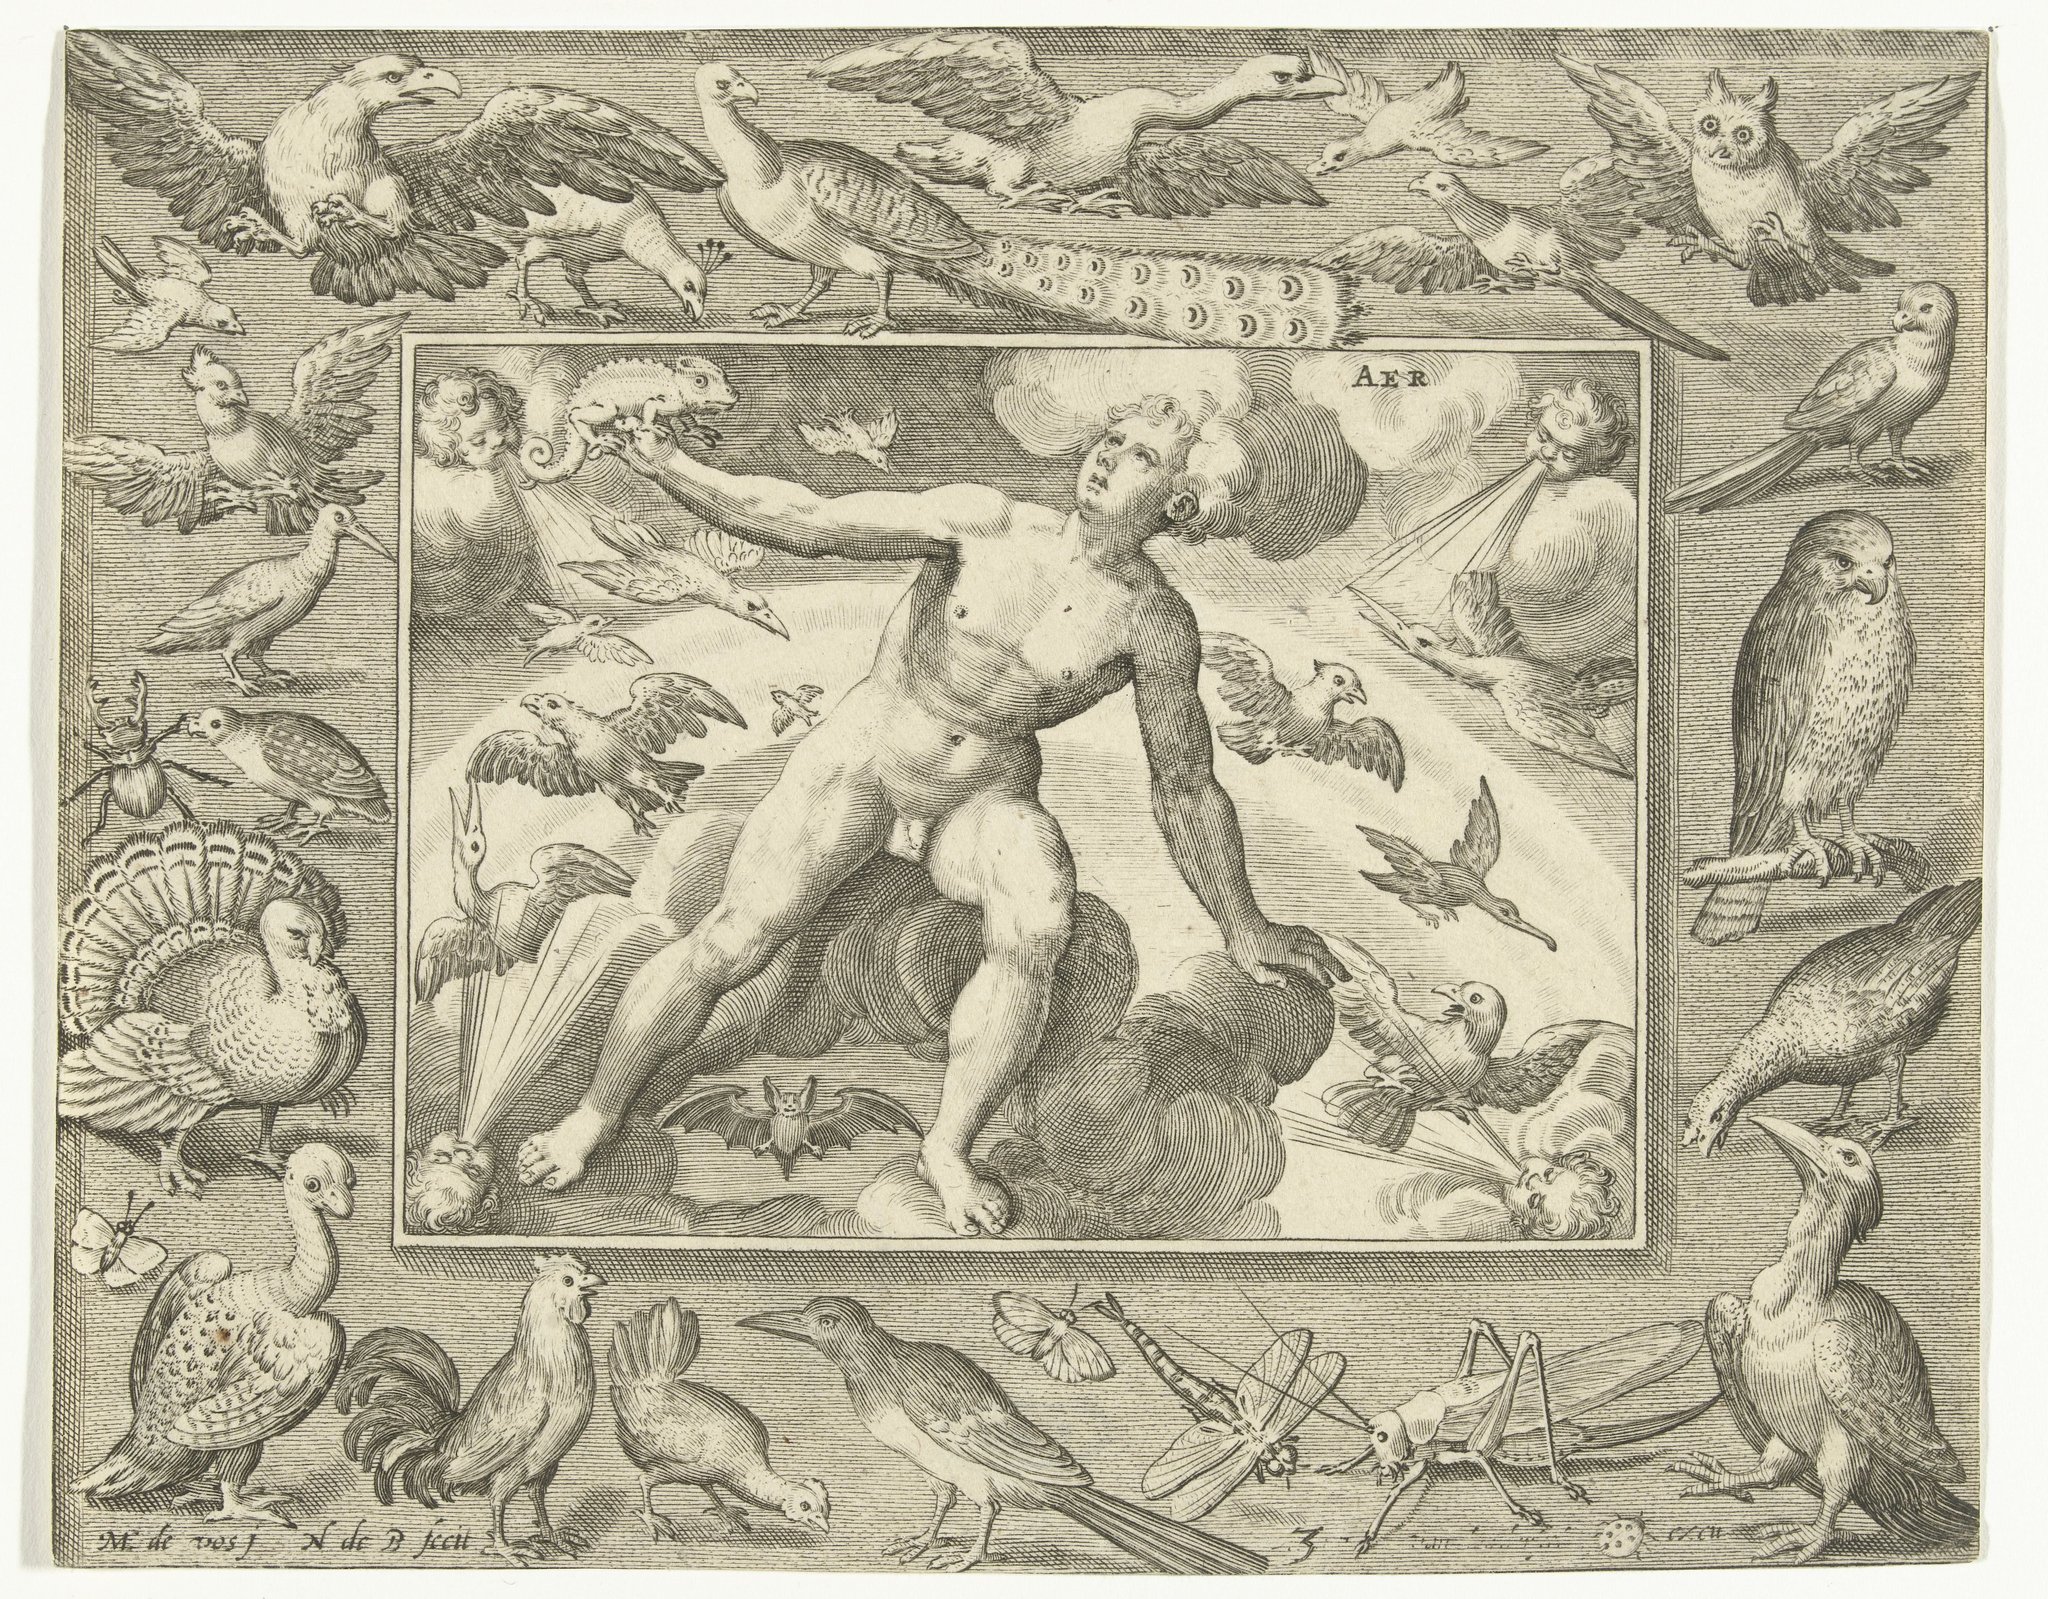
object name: print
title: Aer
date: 1581-1656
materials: paper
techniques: engraving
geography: netherlands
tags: air (one of the four elements), birds, winds, insects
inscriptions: collector's mark: Lugt 2228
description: Element lucht als jonge man zittend op wolken met kameleon op zijn hand tussen vliegende vogels en vleermuis. Van vier windrichtingen blaast de wind. In omlijsting met vogels als uil, pauw en kalkoen en insecten als sprinkhaan en libelle.